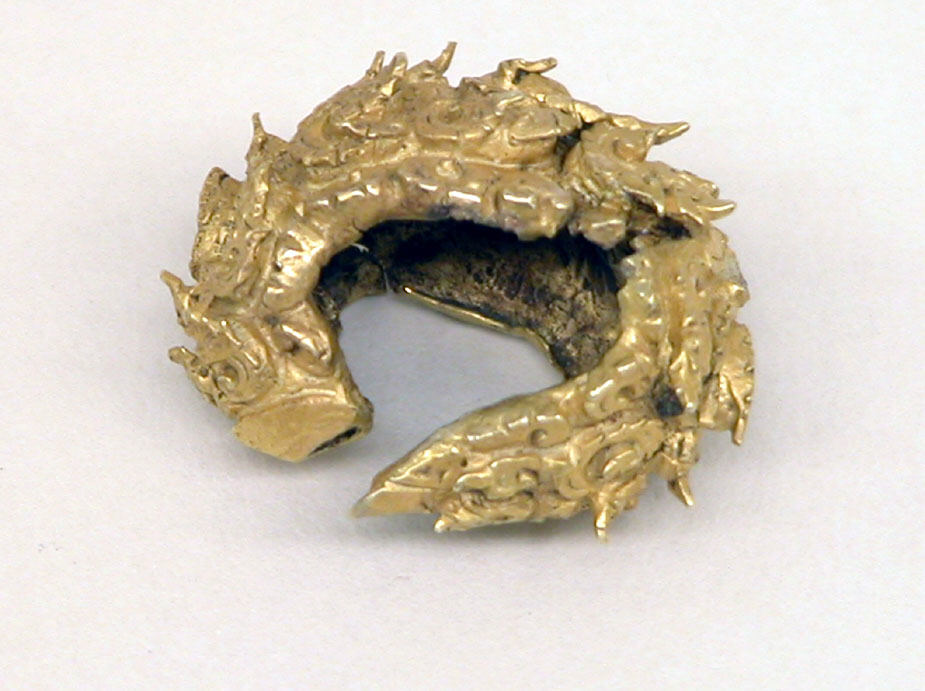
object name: ear ornament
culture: indonesian, javanese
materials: gold